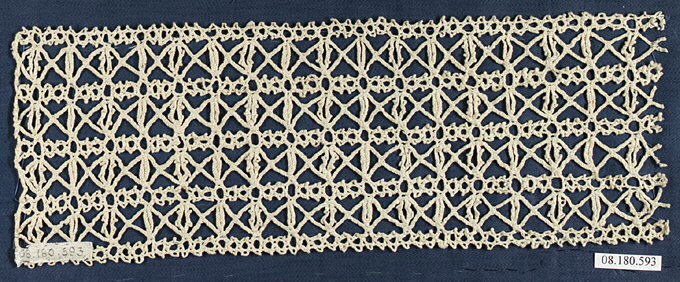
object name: insertion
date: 1601-1700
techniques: lace